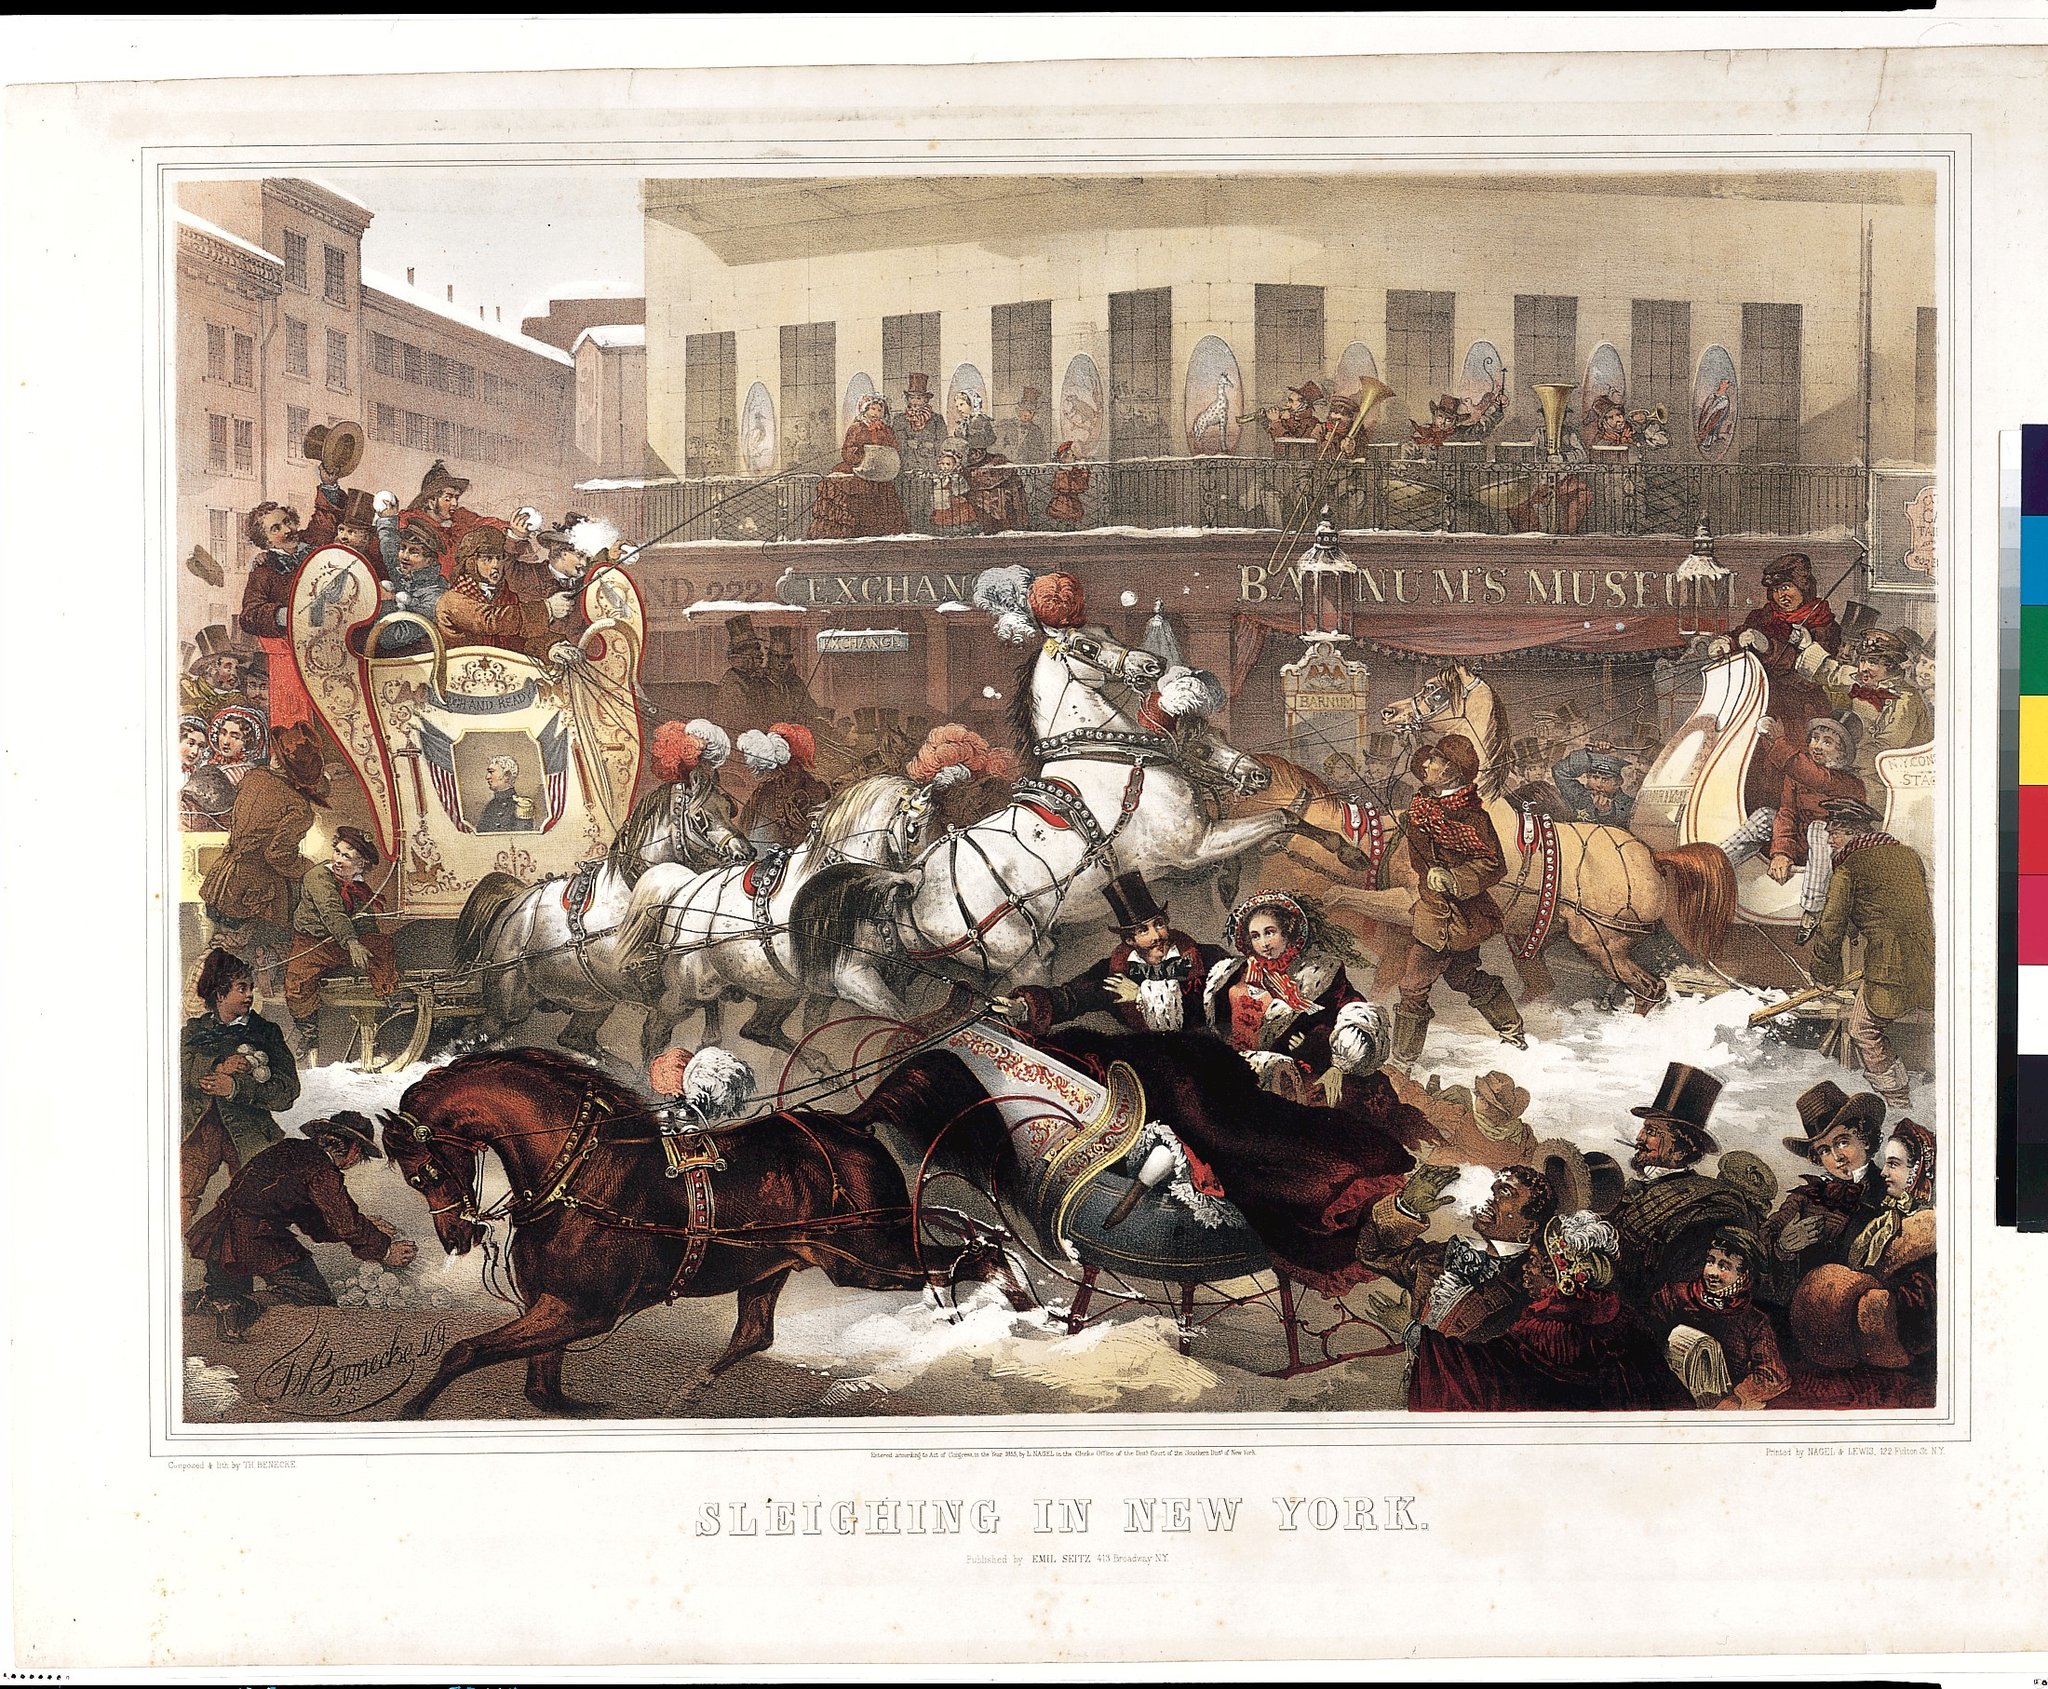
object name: print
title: Sleighing in New York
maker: thomas benecke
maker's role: artist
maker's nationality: american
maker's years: 1855-1856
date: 1855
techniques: hand coloring, lithograph